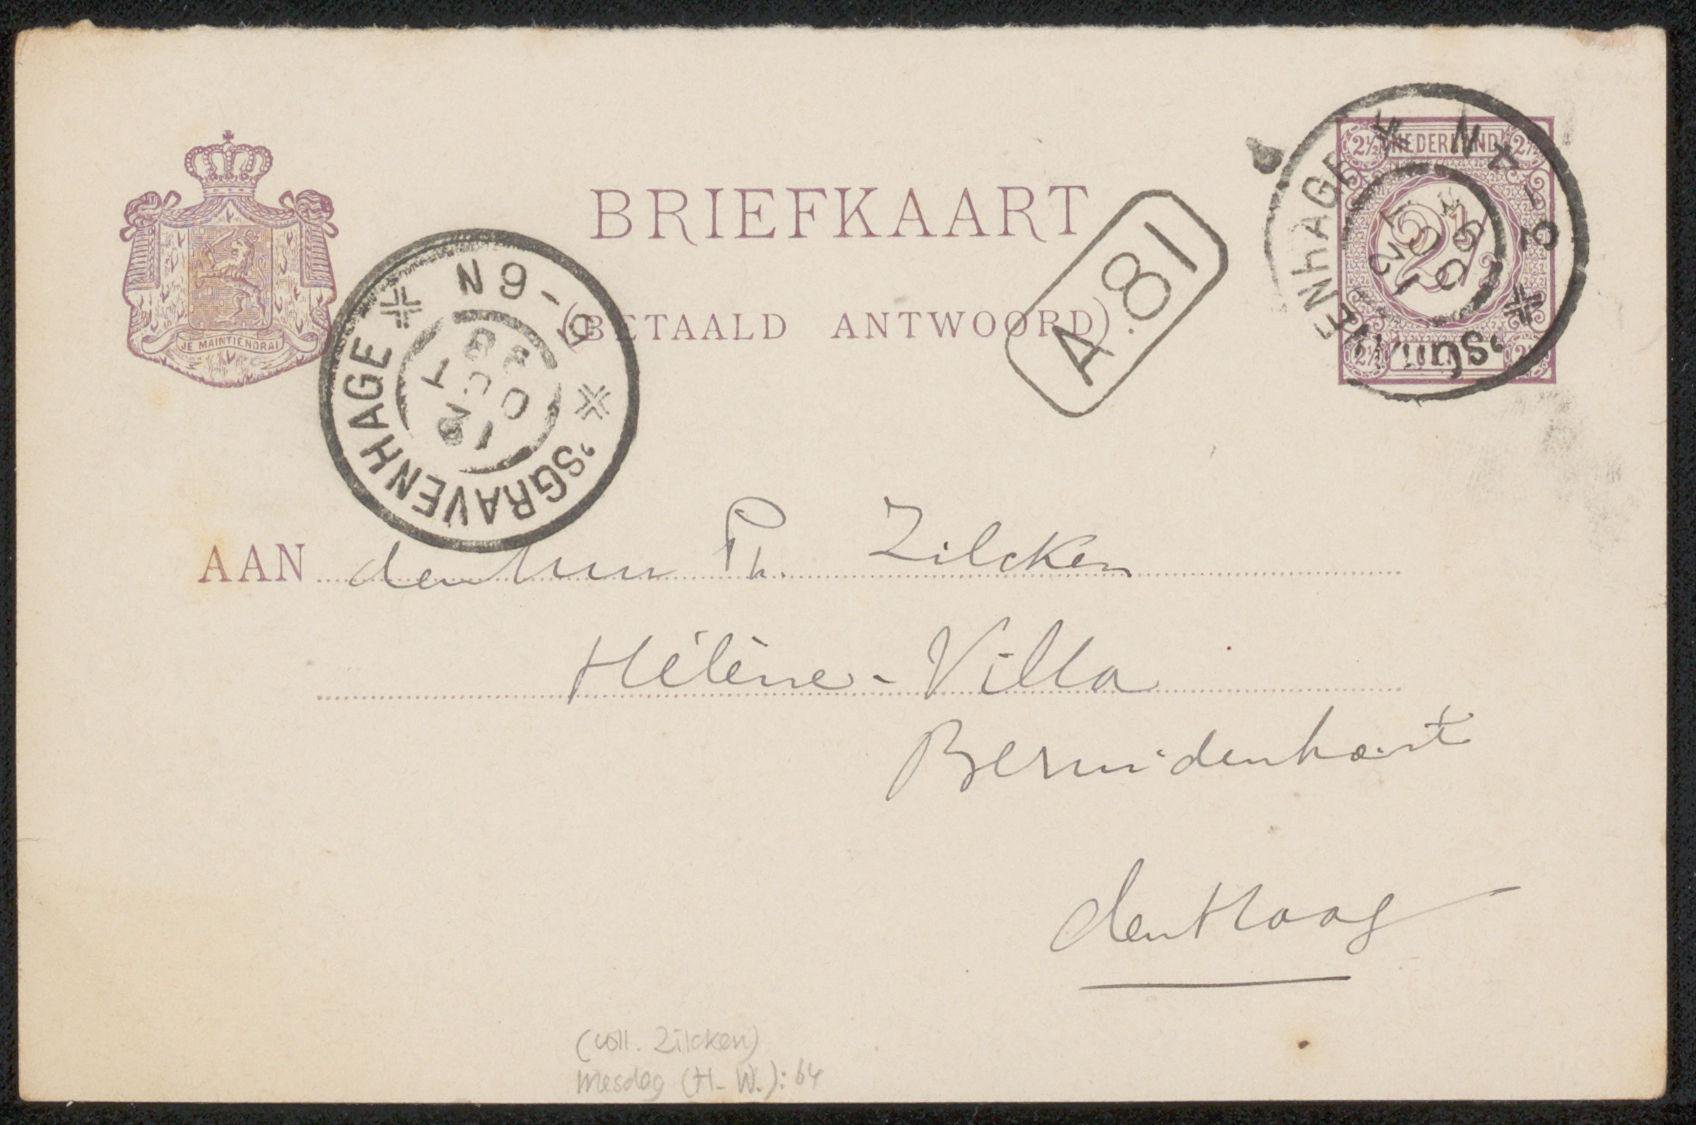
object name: postcard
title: Briefkaart aan Philip Zilcken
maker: hendrik willem mesdag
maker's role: draughtsman, painter, print maker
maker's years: 1831-1915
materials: cardboard, ink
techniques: pen, writing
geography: the hague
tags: philip zilcken, painting (including book-illumination, miniature-painting)